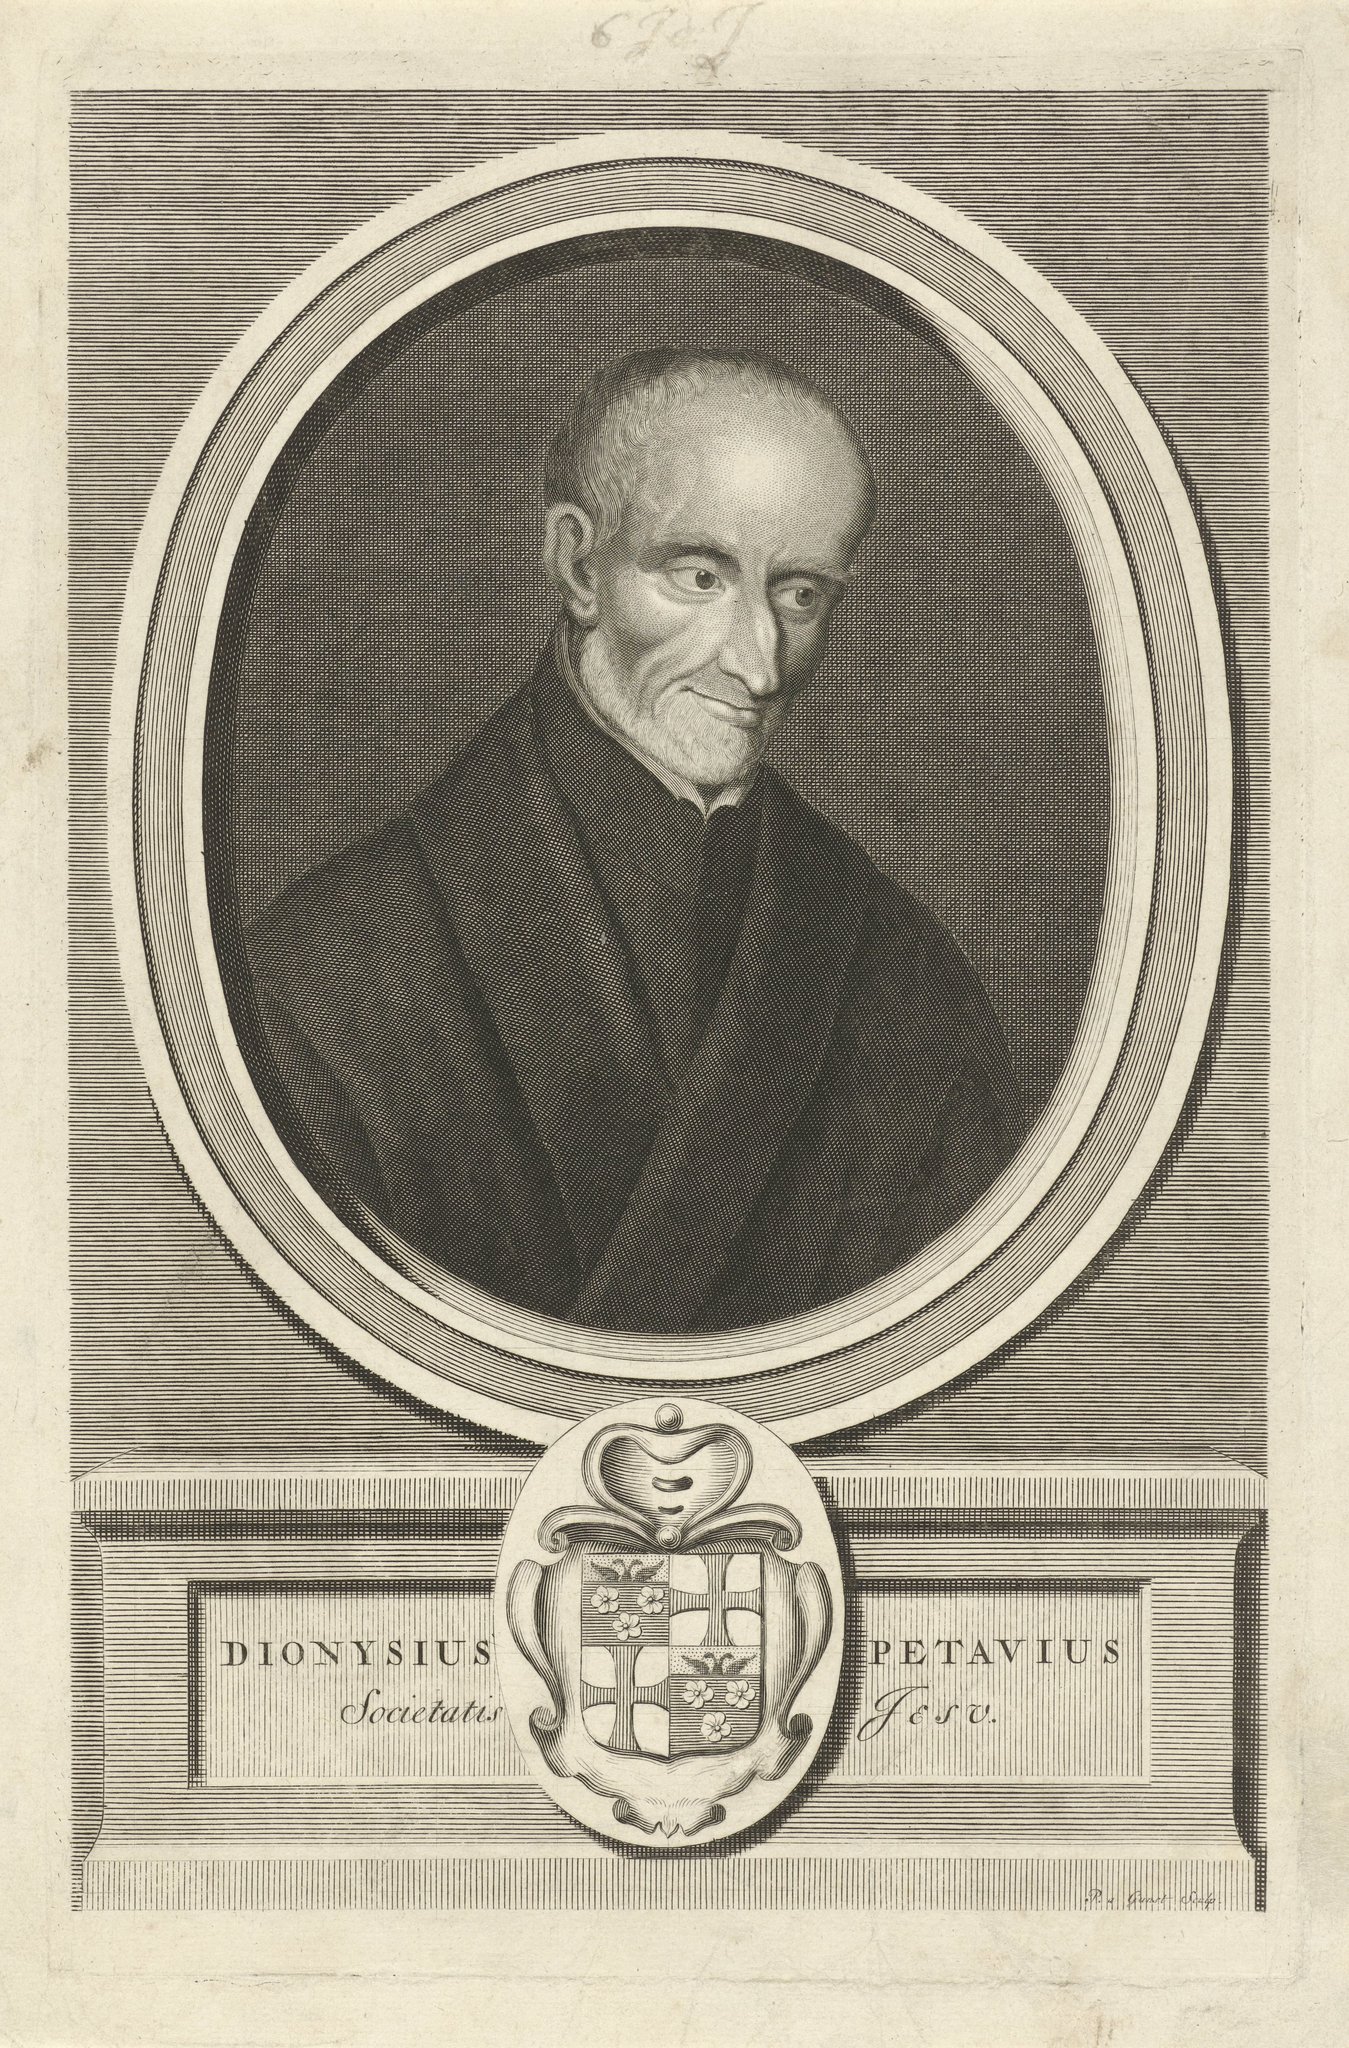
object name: print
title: Portret van Denis Pétau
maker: pieter van gunst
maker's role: print maker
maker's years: 1658-1731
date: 1659-1731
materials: paper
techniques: engraving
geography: amsterdam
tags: paris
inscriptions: collector's mark: Lugt 2228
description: Denis Pétau, een Franse jezuïet, theoloog en historicus. Onder het portret zijn wapenschild.